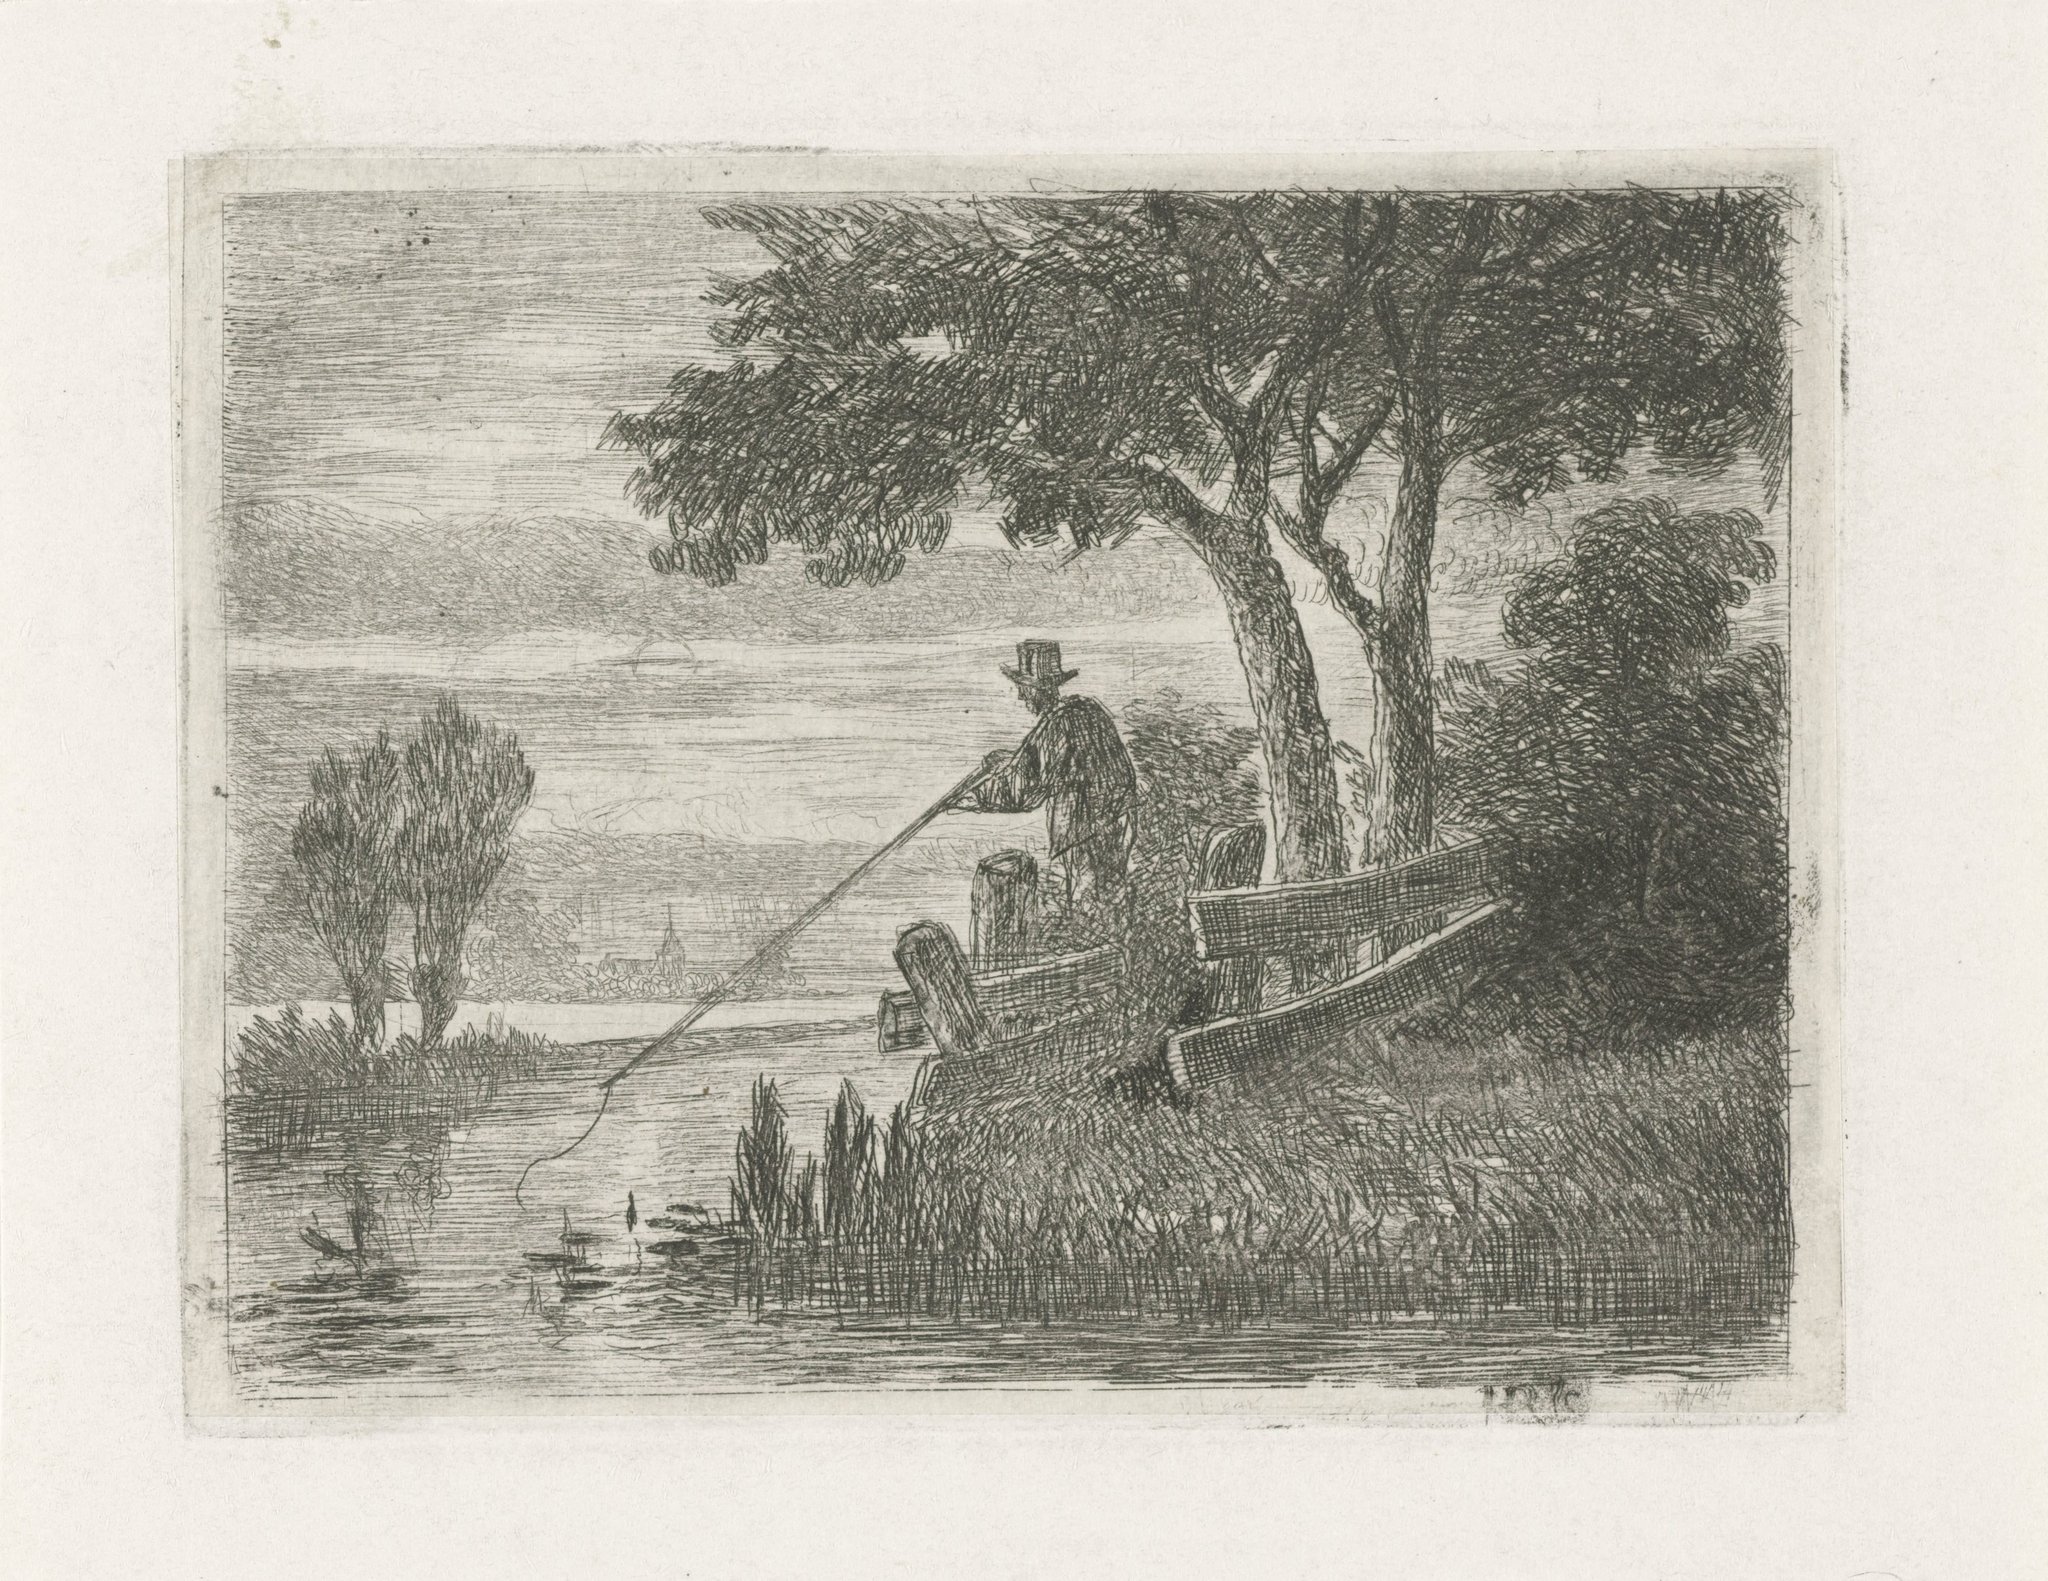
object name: print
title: Visser aan de oever van een rivier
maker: hermanus jan hendrik van rijkelijkhuysen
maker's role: painter, print maker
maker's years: 1813-1883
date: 1823-1883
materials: paper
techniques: etching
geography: utrecht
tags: river, church (exterior), fisherman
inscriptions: collector's mark: Lugt 2228